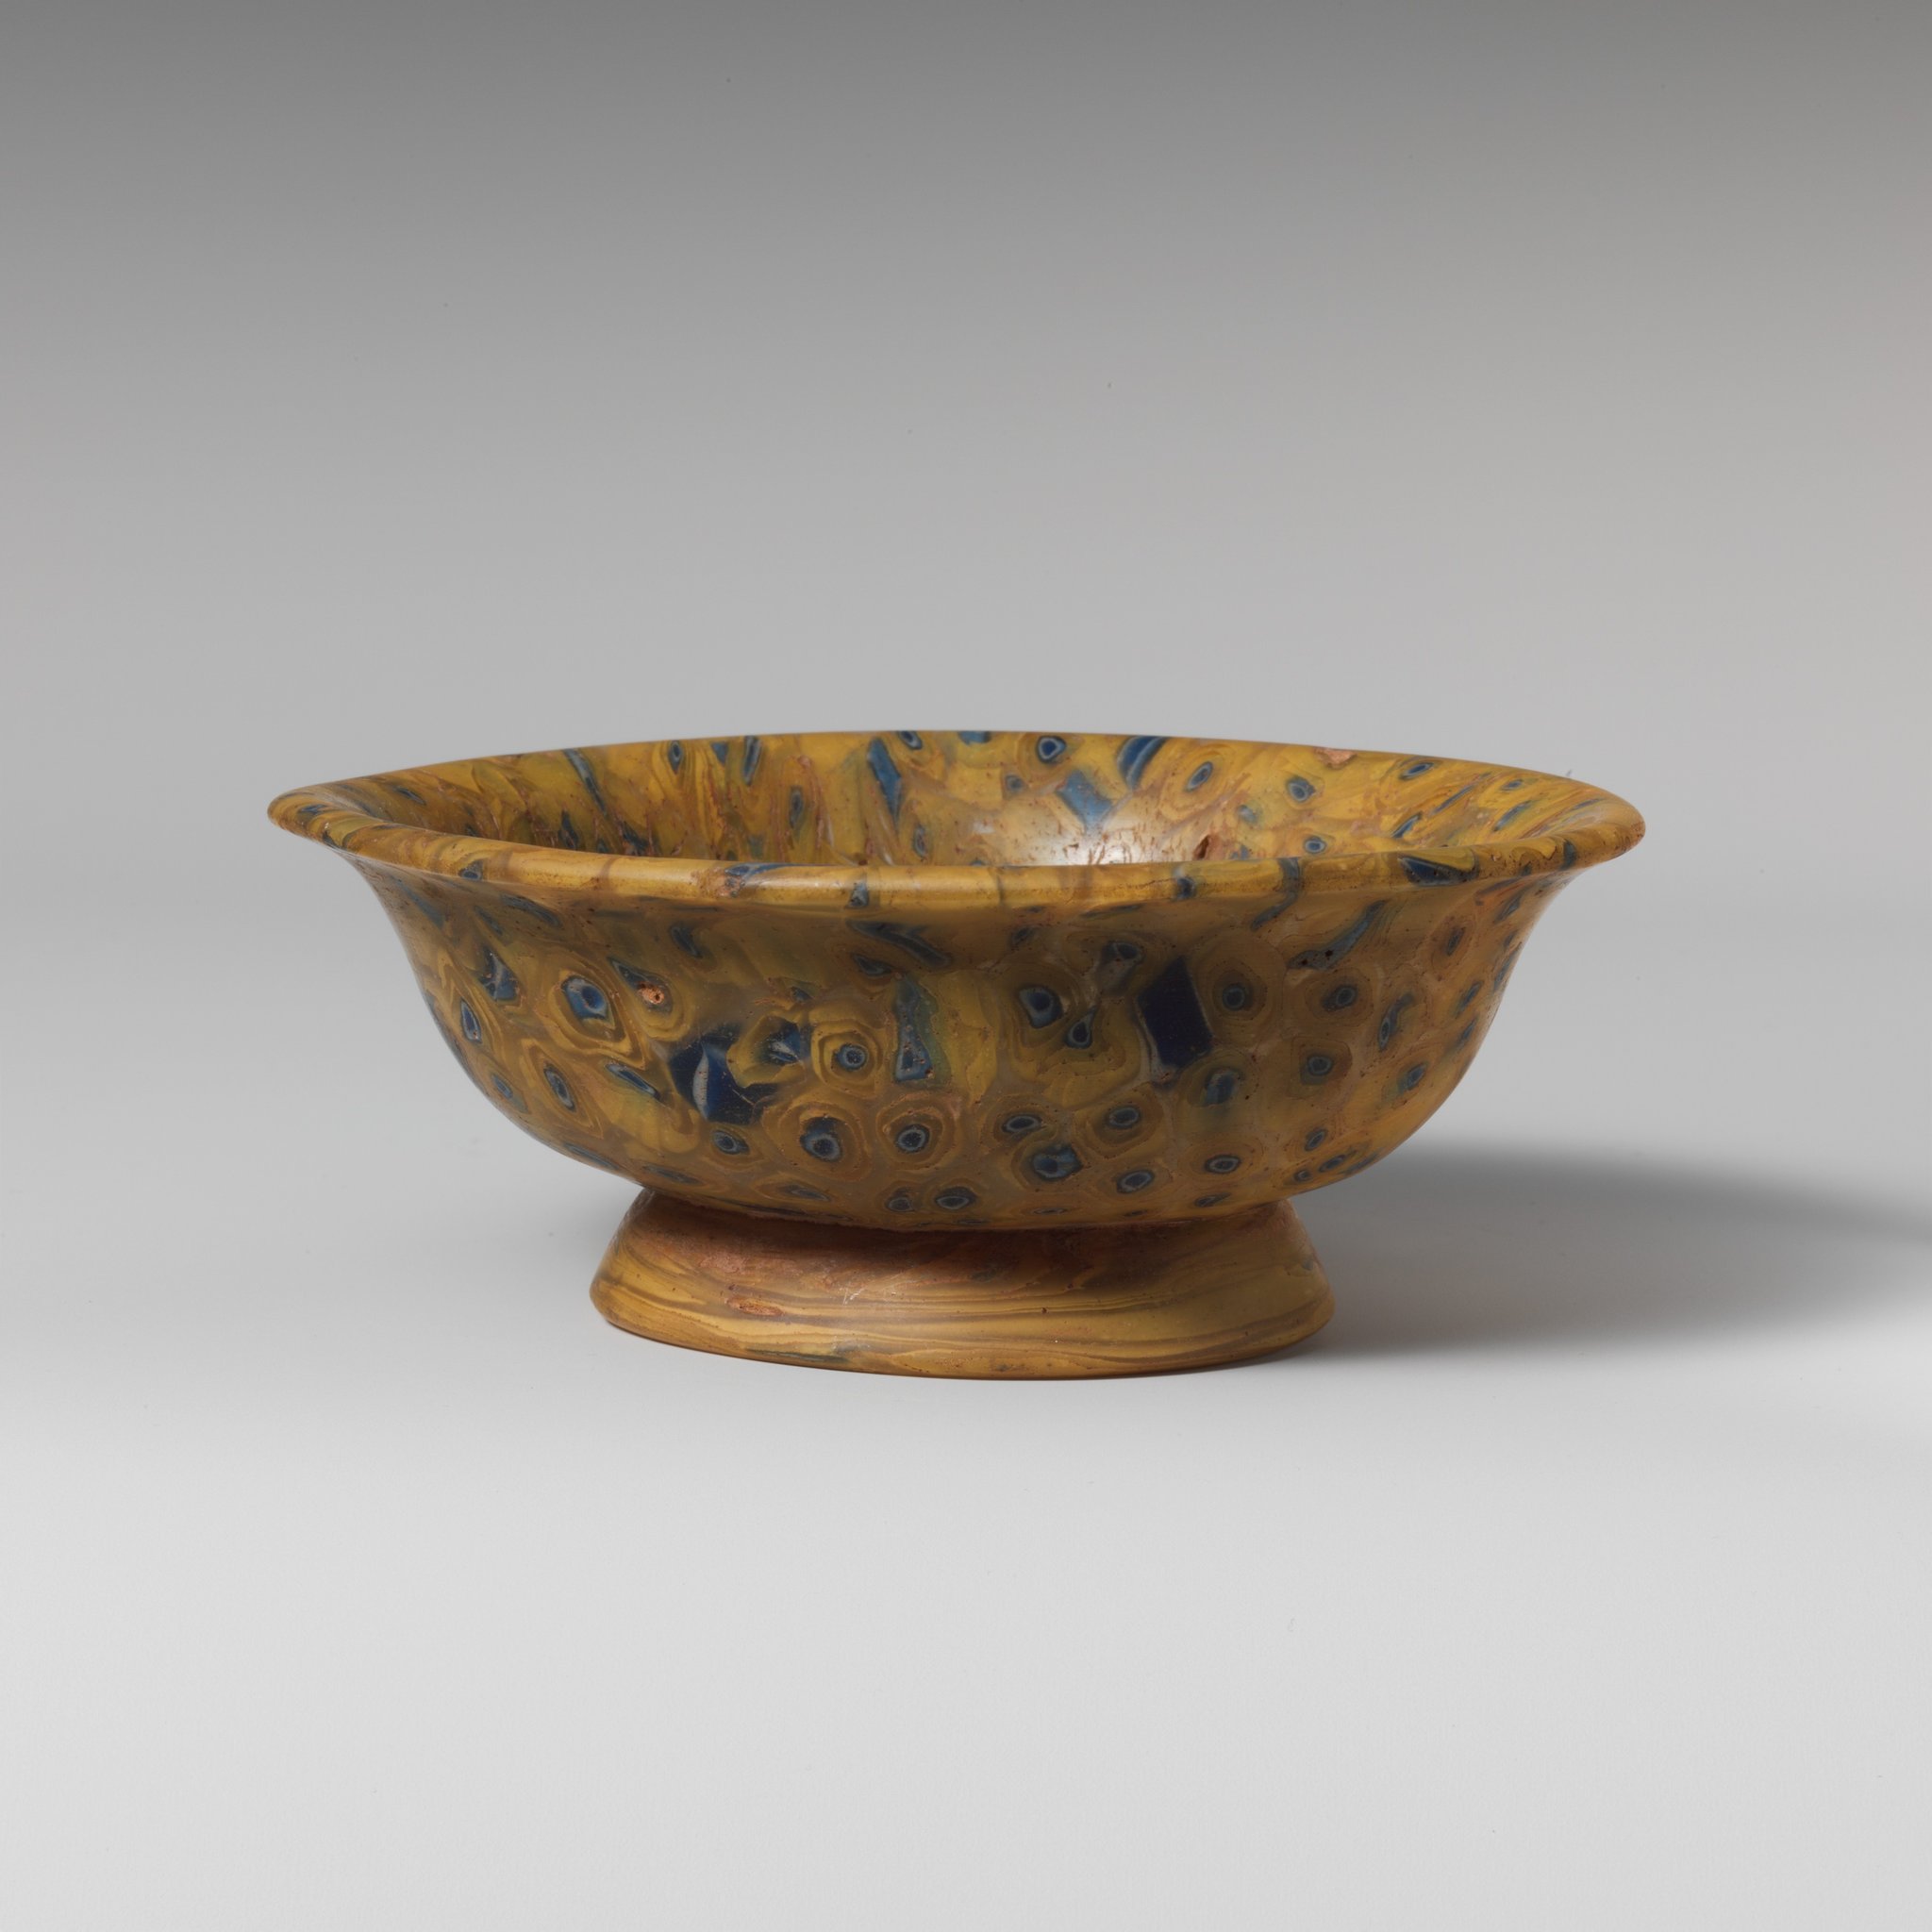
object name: millefiori bowl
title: Glass mosaic bowl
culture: greek or roman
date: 200-1 BCE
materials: glass